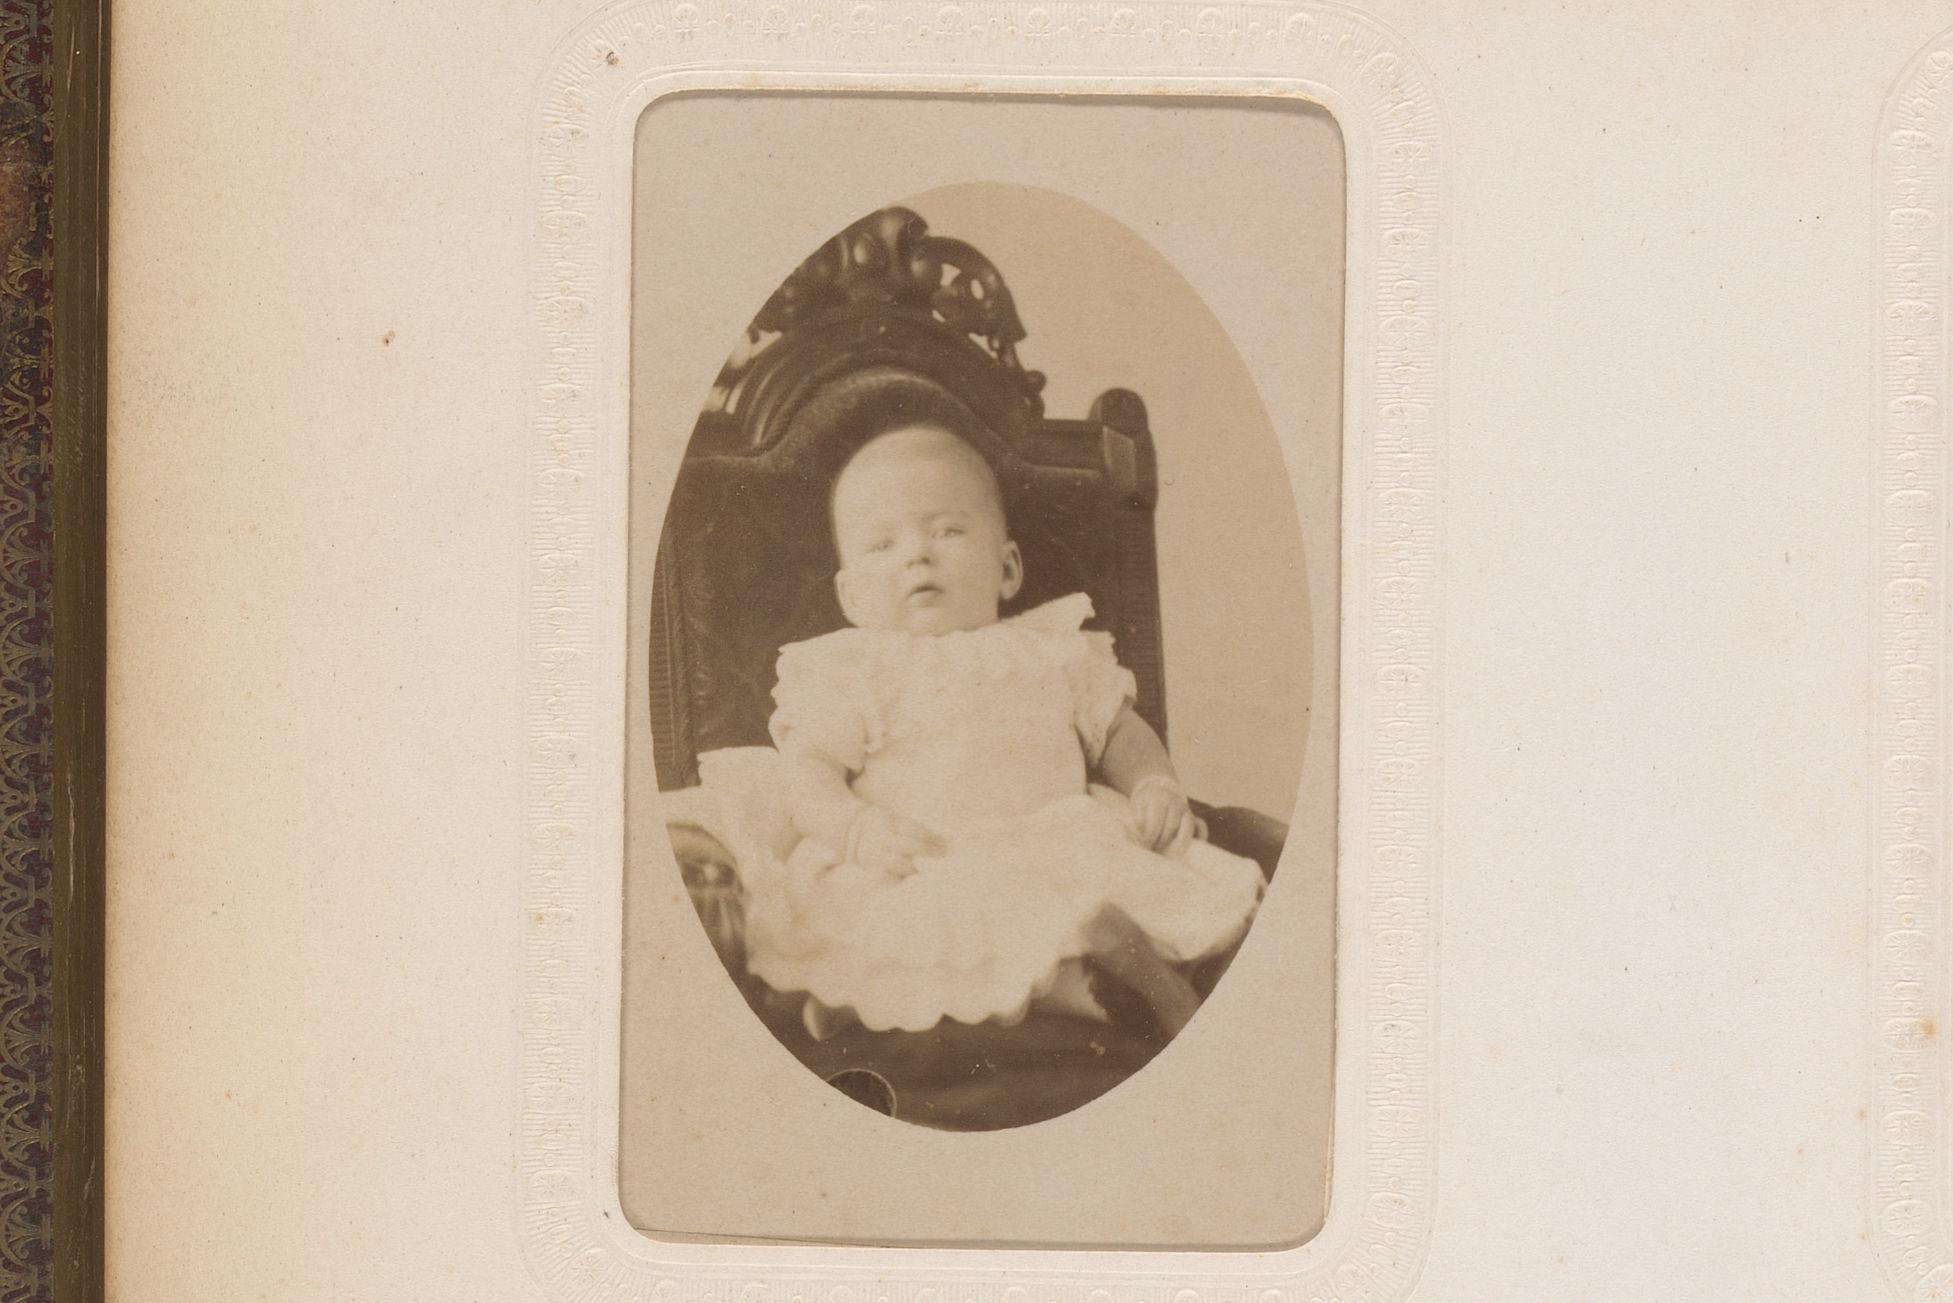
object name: semi enamel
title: Portret van twee peuters en een baby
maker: Anonymous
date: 1880-1900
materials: cardboard, celluloid, photographic support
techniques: albumen print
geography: netherlands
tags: toddler (female) (+ two persons), infant, baby ~ the ages of man, anonymous historical persons portrayed in a group, in a group-portrait